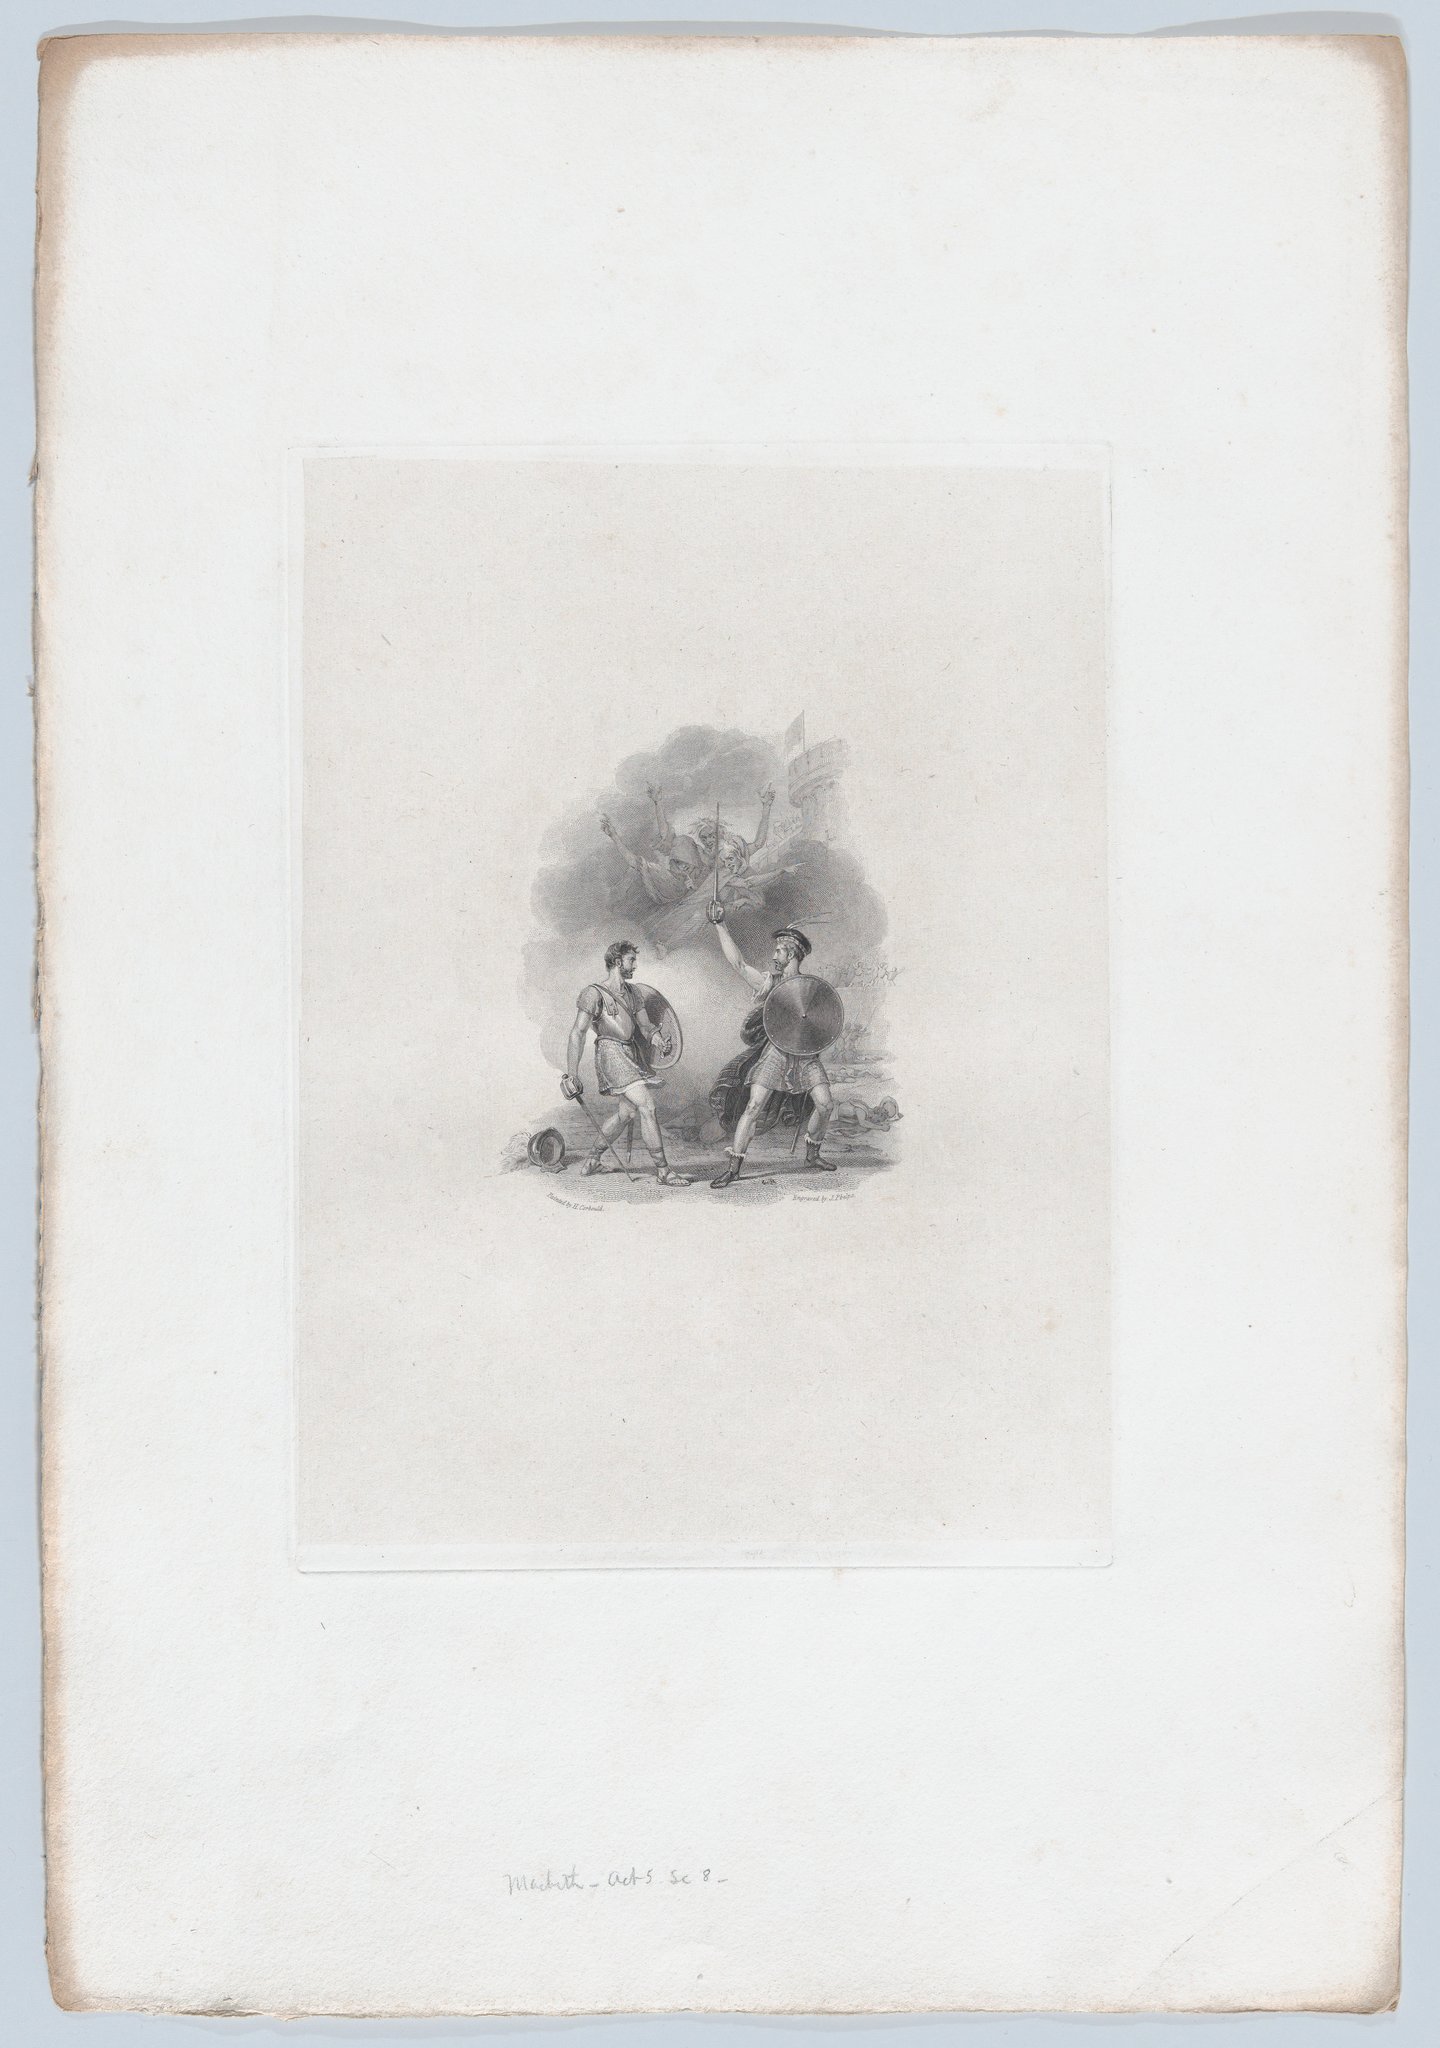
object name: print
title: Macbeth and Macduff (Shakespeare, Macbeth, Act 5, Scene 8)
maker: joseph phelps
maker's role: engraver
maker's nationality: british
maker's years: 1808-1829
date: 1827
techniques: printmaking, engraving, etching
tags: shields,shakespeare,men,macbeth